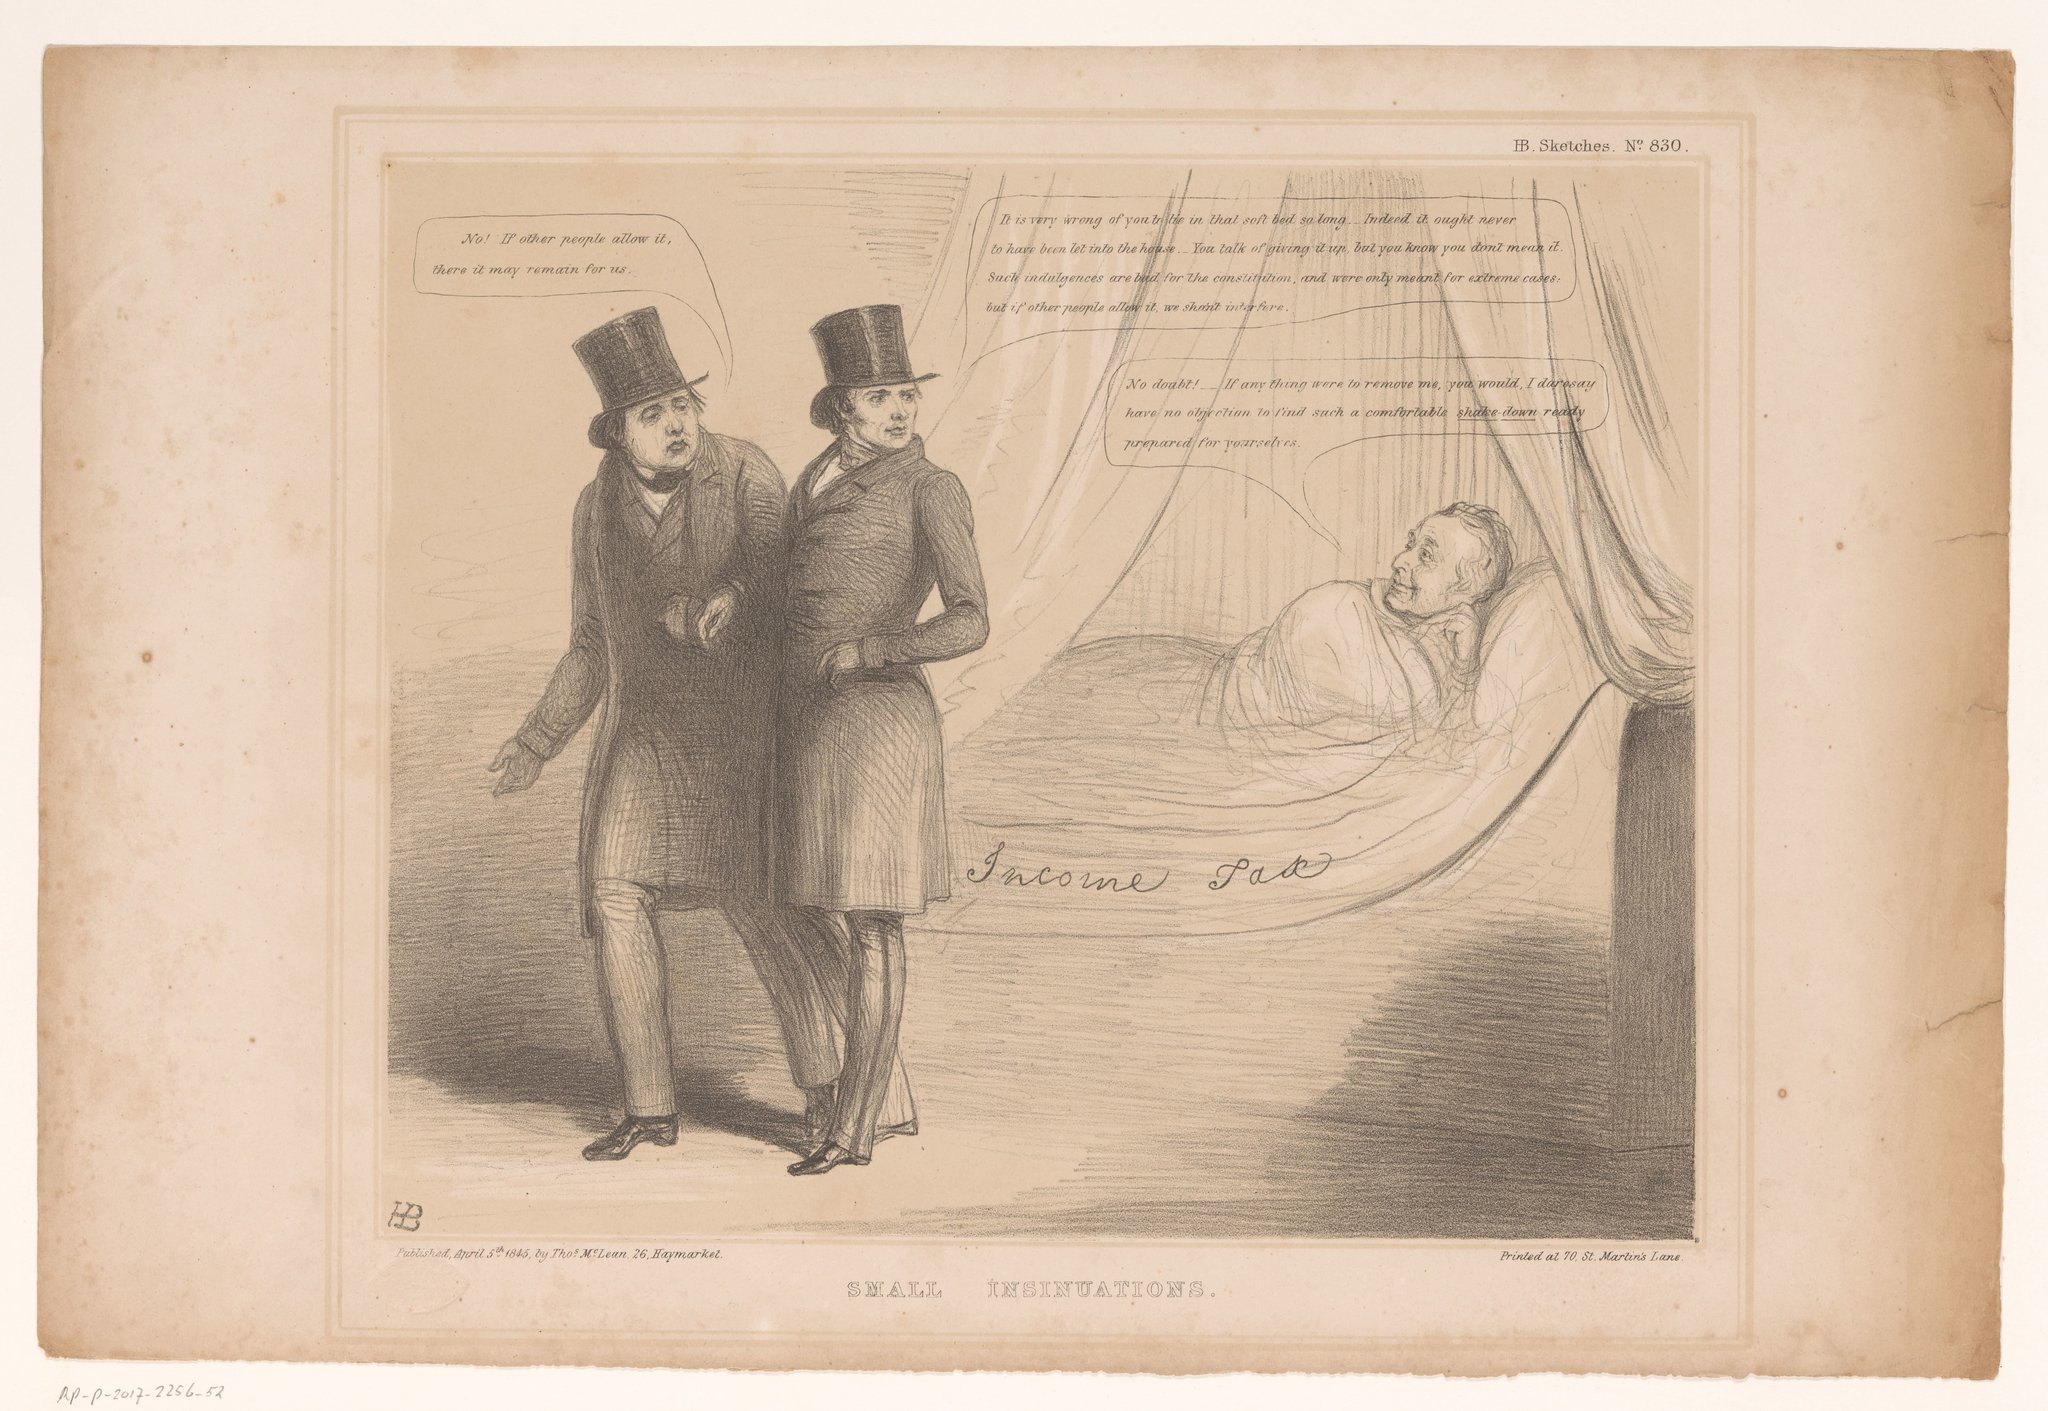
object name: print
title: HB Sketches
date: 1845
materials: paper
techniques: tone lithography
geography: london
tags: politician, bed, political caricatures and satires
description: Spotprent uit 1845 waarin premier Robert Peel tevreden in een comfortabel bed 'income tax' ligt, tot ongenoegen van twee andere heren, waaronder Lord Russell. Uitgegeven als nr. 830 in de serie HB Sketches.